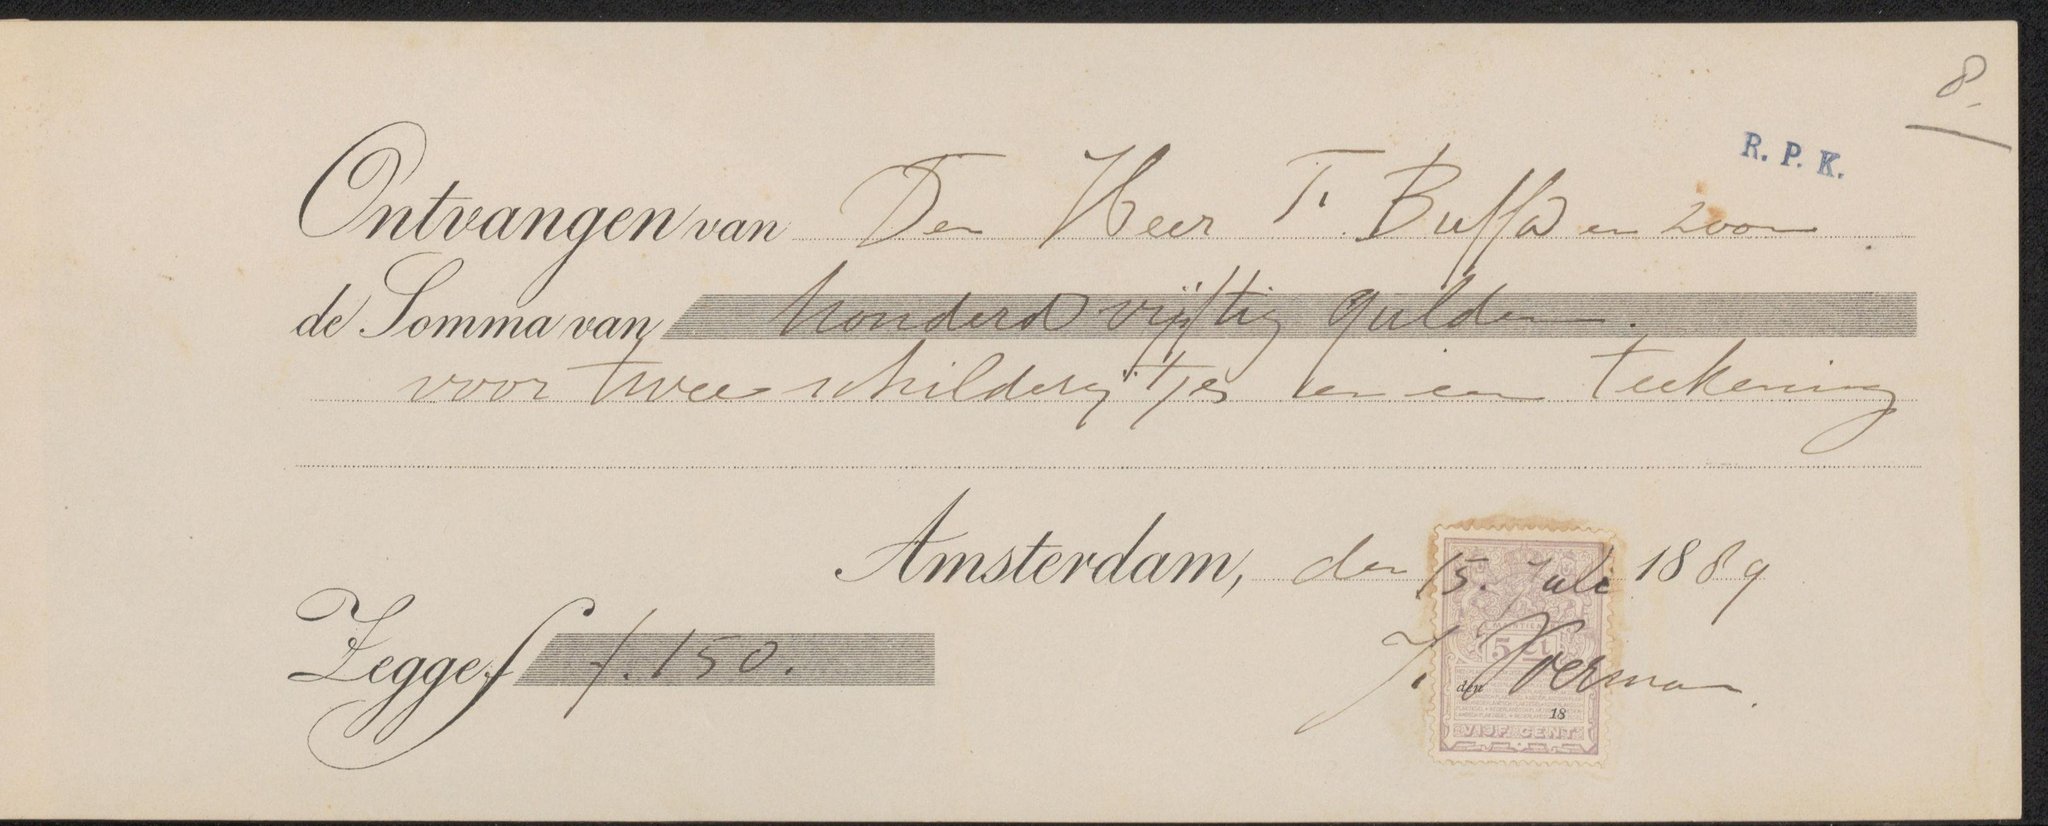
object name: ontvangstbewijs, kwitantie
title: Kwitantie voor Jan Voerman (1857-1941)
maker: jan voerman (1857-1941)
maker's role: draughtsman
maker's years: 1857-1941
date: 1889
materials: ink, paper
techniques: pen, printing, writing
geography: amsterdam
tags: drawing, painting (including book-illumination, miniature-painting), money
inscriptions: collector's mark: Lugt 2233